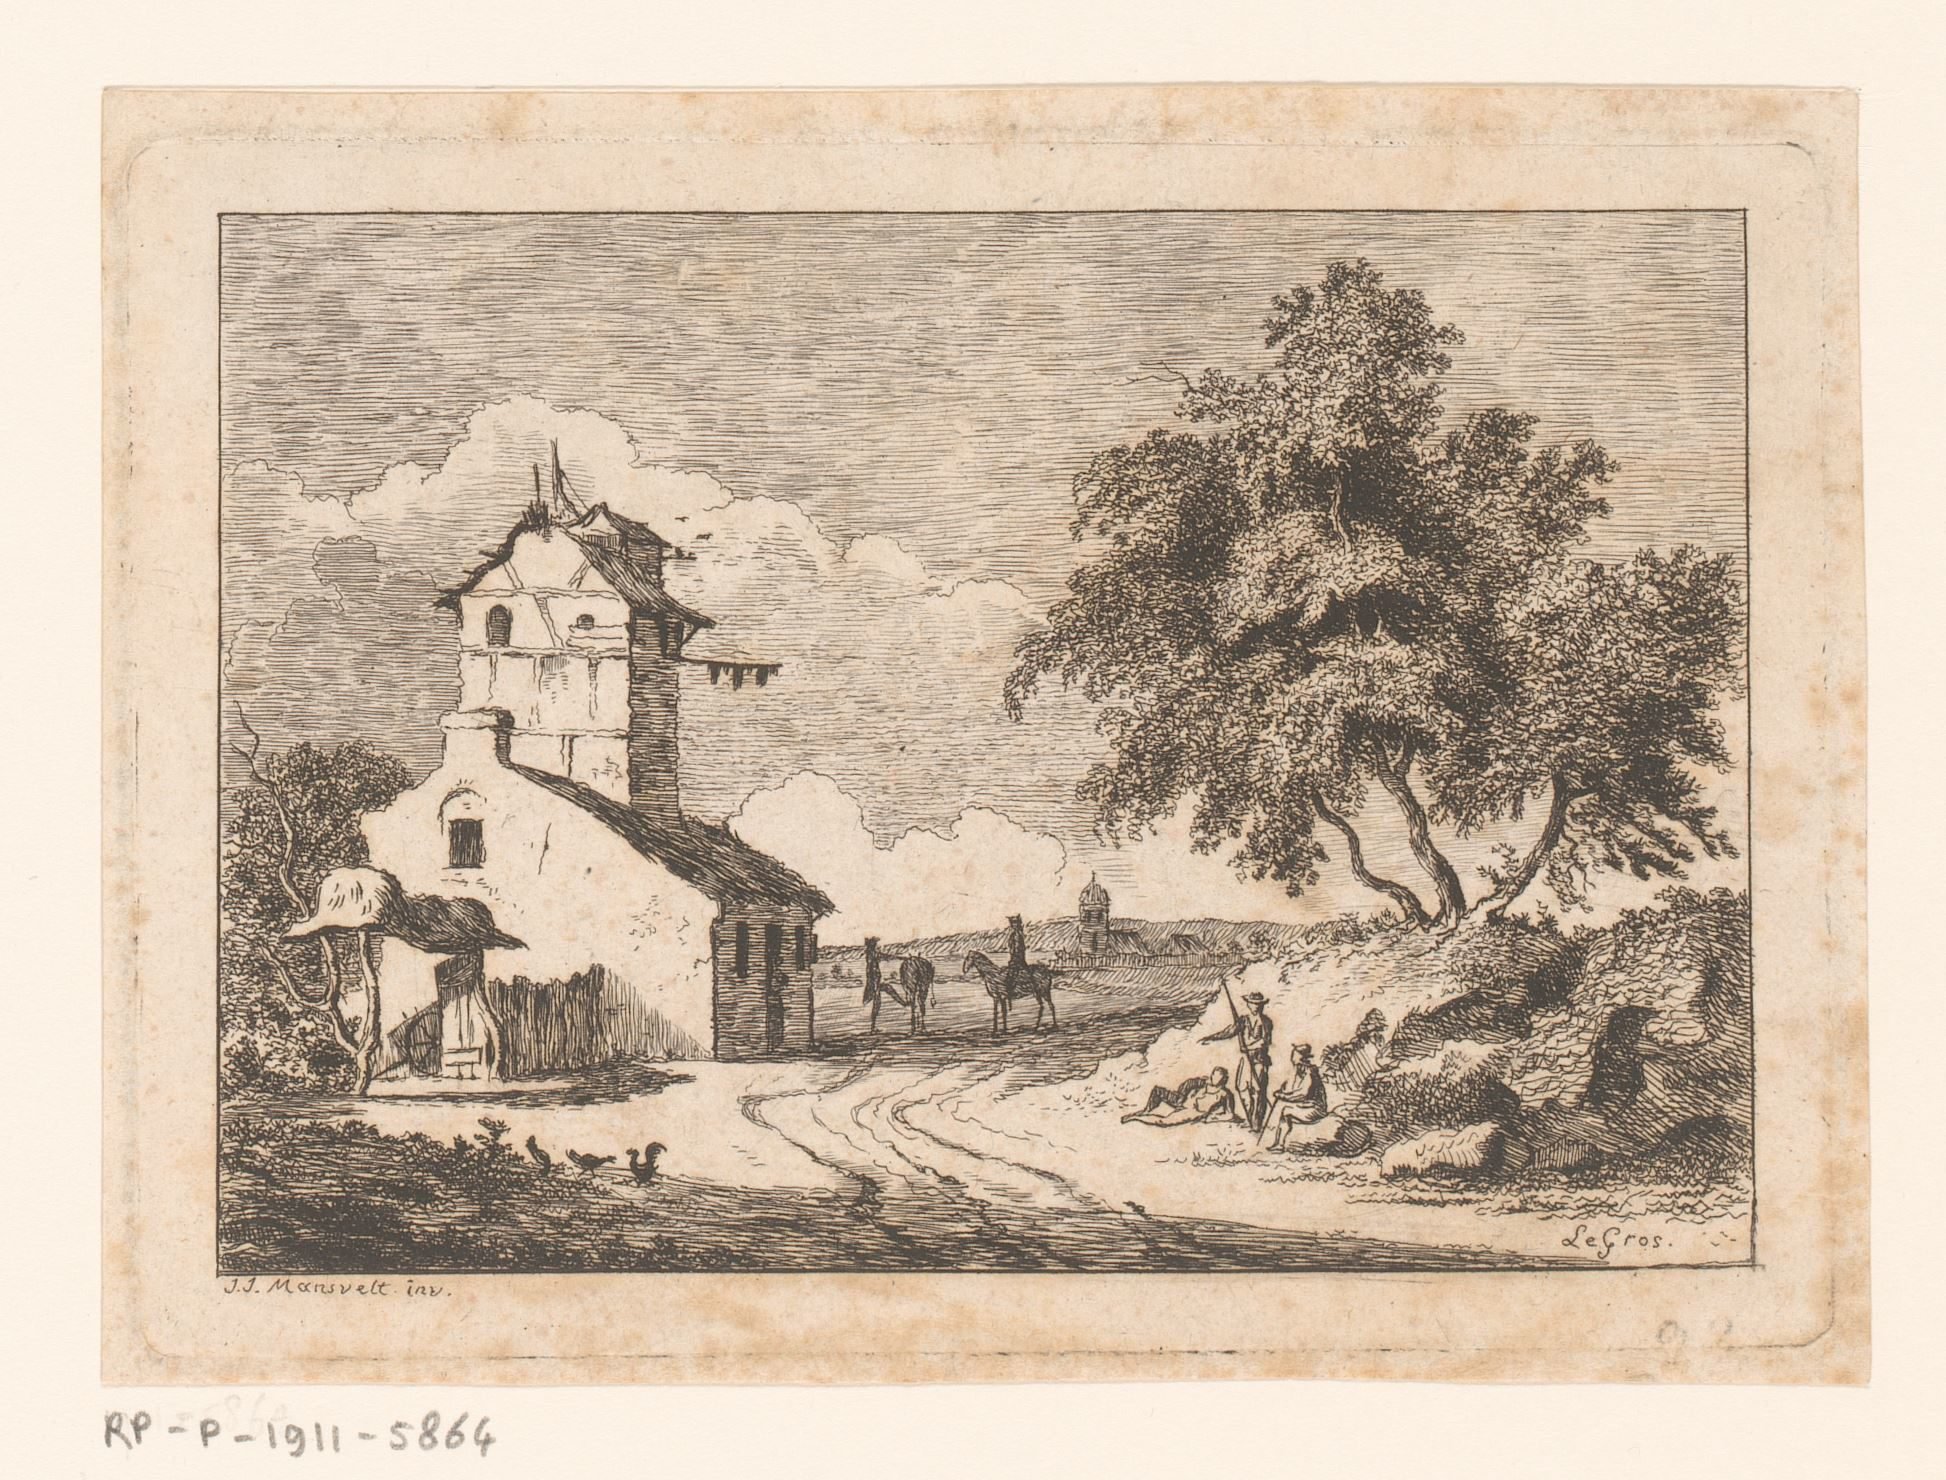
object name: print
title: Landschap met een huis met een toren en reizigers langs een pad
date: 1764-1834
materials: paper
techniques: etching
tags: road, path, landscapes in the temperate zone (+ landscape with figures, staffage), farm or solitary house in landscape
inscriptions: collector's mark: Lugt 2228